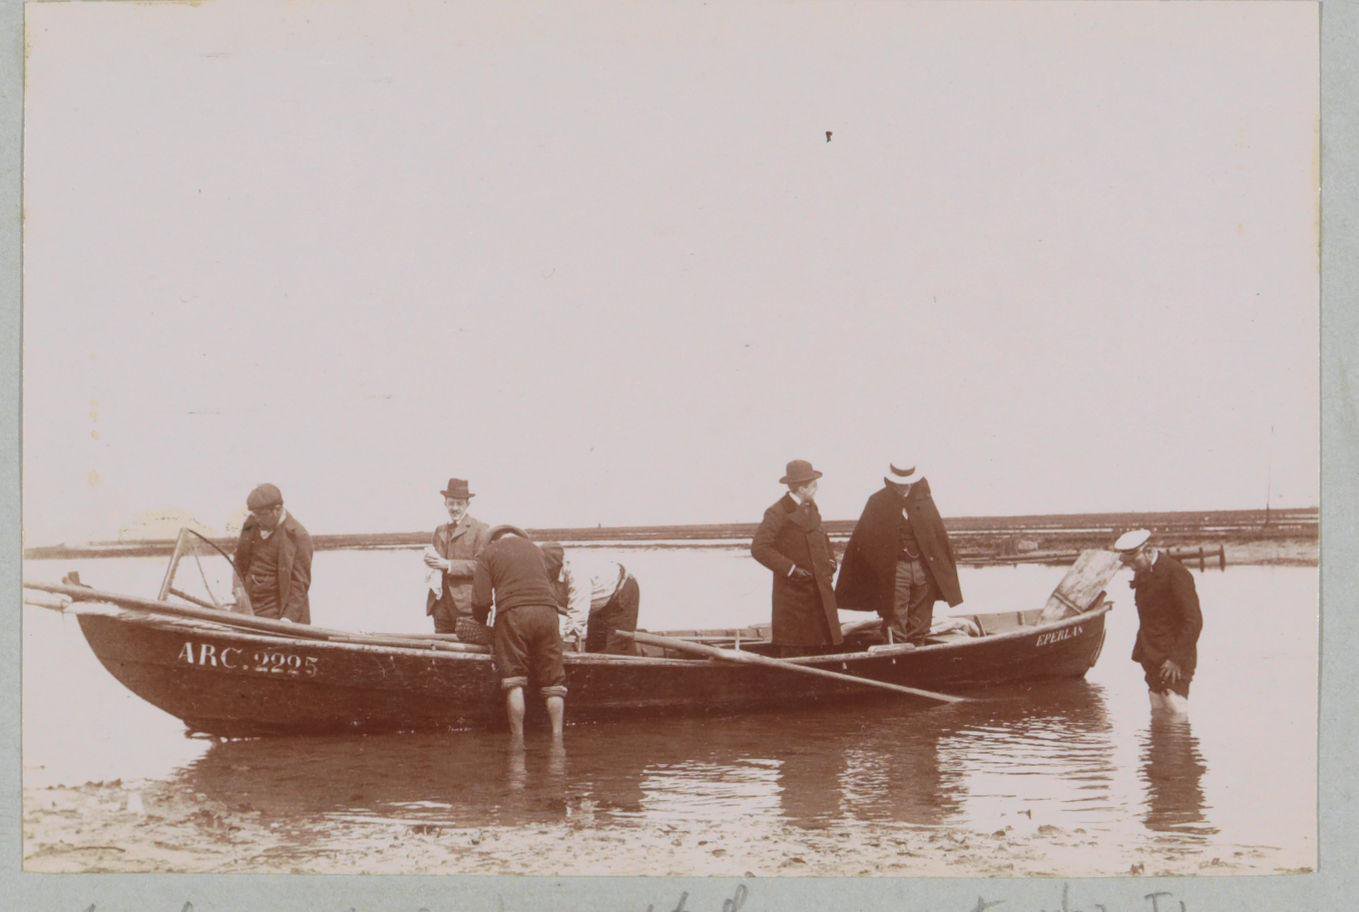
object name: photograph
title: Gezelschap bij een roeiboot aan de kust bij Arcachon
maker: delizy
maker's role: manufacturer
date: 1804-1898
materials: paper, photographic support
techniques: gelatin silver print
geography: arcachon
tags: rowing-boat, canoe, etc.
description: Onderdeel van Fotoalbum van een Franse amateurfotograaf met opnames van uitstapjes in Frankrijk, Spanje, België, Luxemburg en Nederland, de eerste automobielen en autoraces.